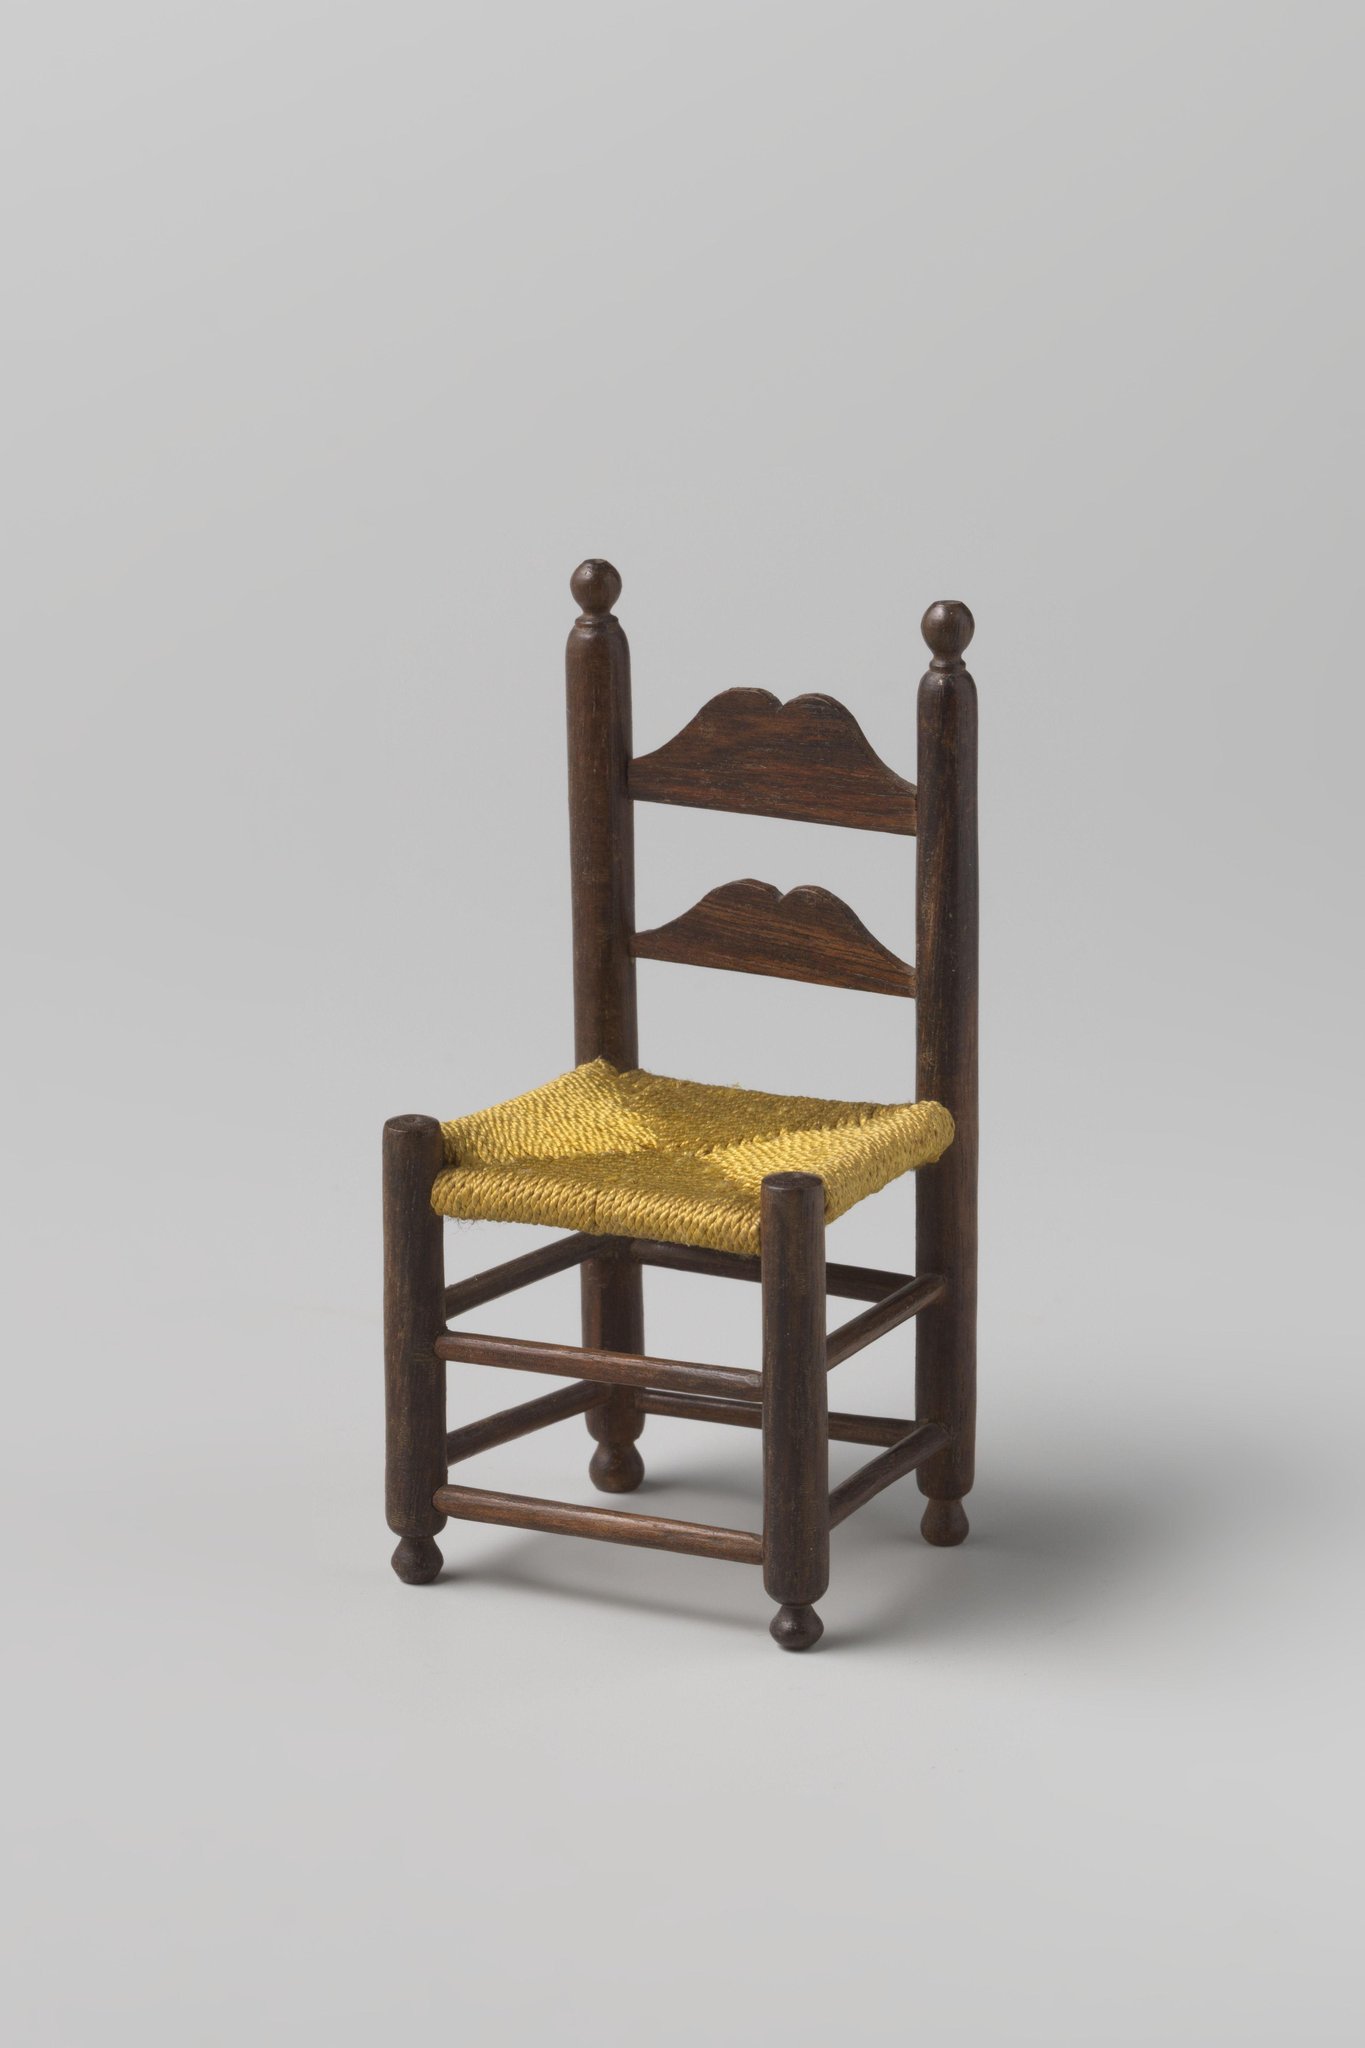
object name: chair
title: Stoel van notenhout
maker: Anonymous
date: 1676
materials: silk, wood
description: Stoel van notenhout met gladde gedraaide stijlen en dwarsregels. De poten en rugstijlen eindigend in bollen. De rugleuning met twee platte dwarssporten in dubbele boog gezaagd. De zitting imitatie mattenbies, gevlochten van geel, getwist zijden koord.